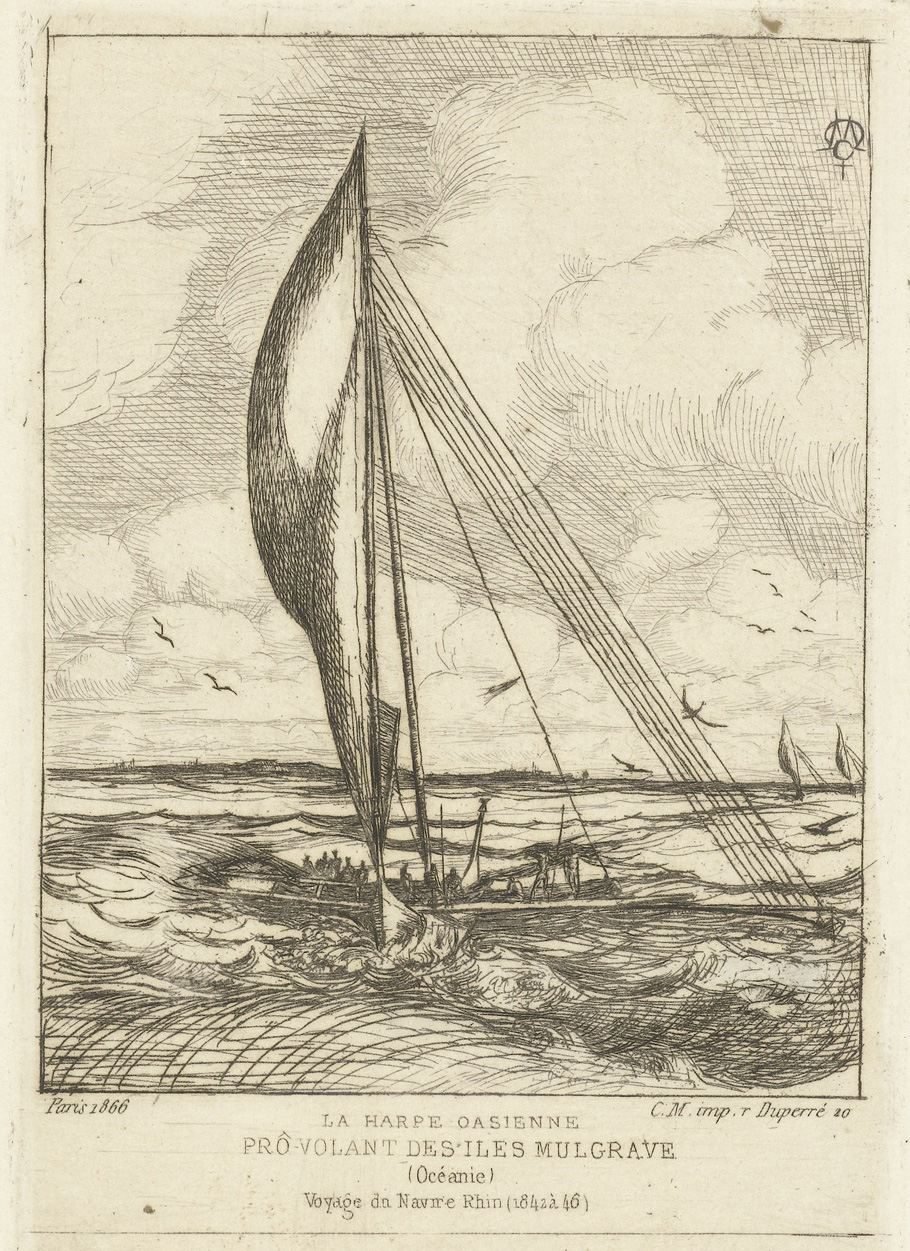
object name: print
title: Zeilschip op Stille Oceaan bij Marshall eilanden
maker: charles meryon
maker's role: print maker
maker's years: 1821-1868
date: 1866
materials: paper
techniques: drypoint, etching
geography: paris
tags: sailing-ship, sailing-boat, sea (seascape)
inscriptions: collector's mark: Lugt 413, collector's mark: Lugt 394, inscription: ‘Etat tout particulier ... des Ils Mulgrave C.M.’, collector's mark: stempel R. Vroom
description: Meryon maakte als luitenant een reis op de boot Le Rhin in de periode 1842-1846 en tekende bezienswaardigheden onderweg. Twintig jaar later werkt hij aan een plan om de tekeningen van de reis uit te geven in prent. Deze ets maakt deel uit van dat initiatief. Van deze staat drukte de kunstenaar twintig exemplaren.